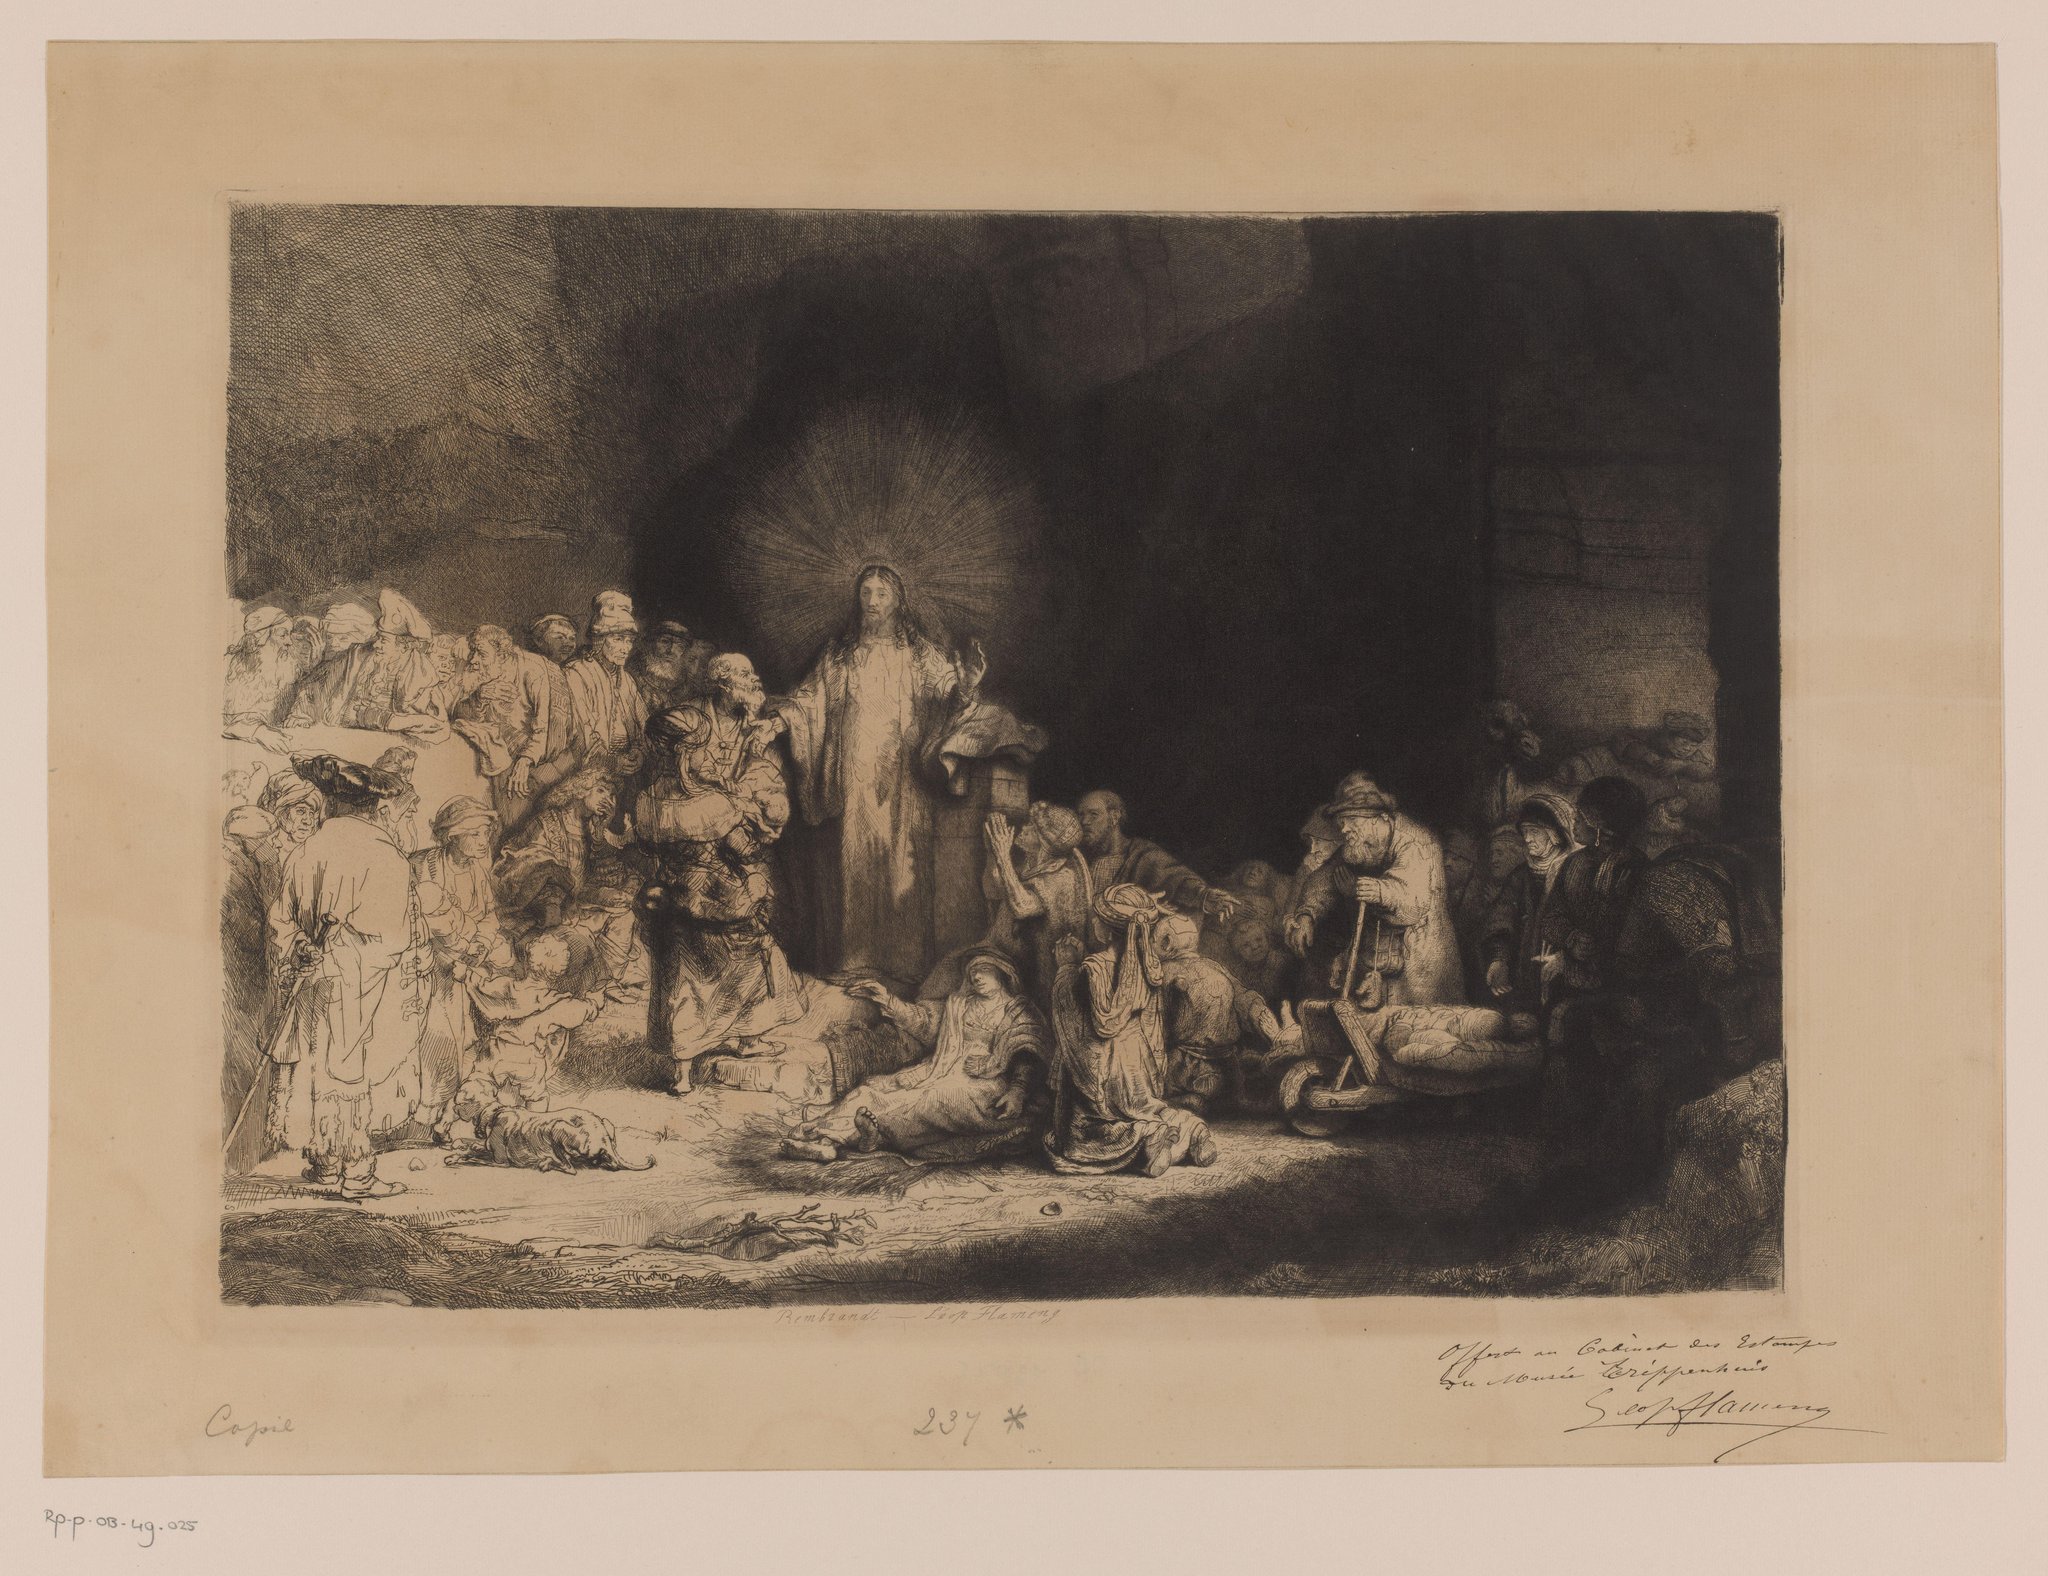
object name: print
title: De Honderdguldenprent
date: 1841-1874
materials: paper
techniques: drypoint, etching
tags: christ preaching or teaching (in general)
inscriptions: collector's mark: Lugt 2228, annotation: ‘Offert au Cabinet des Estampes du Musée Trippenhuis [signatuur prentmaker]’